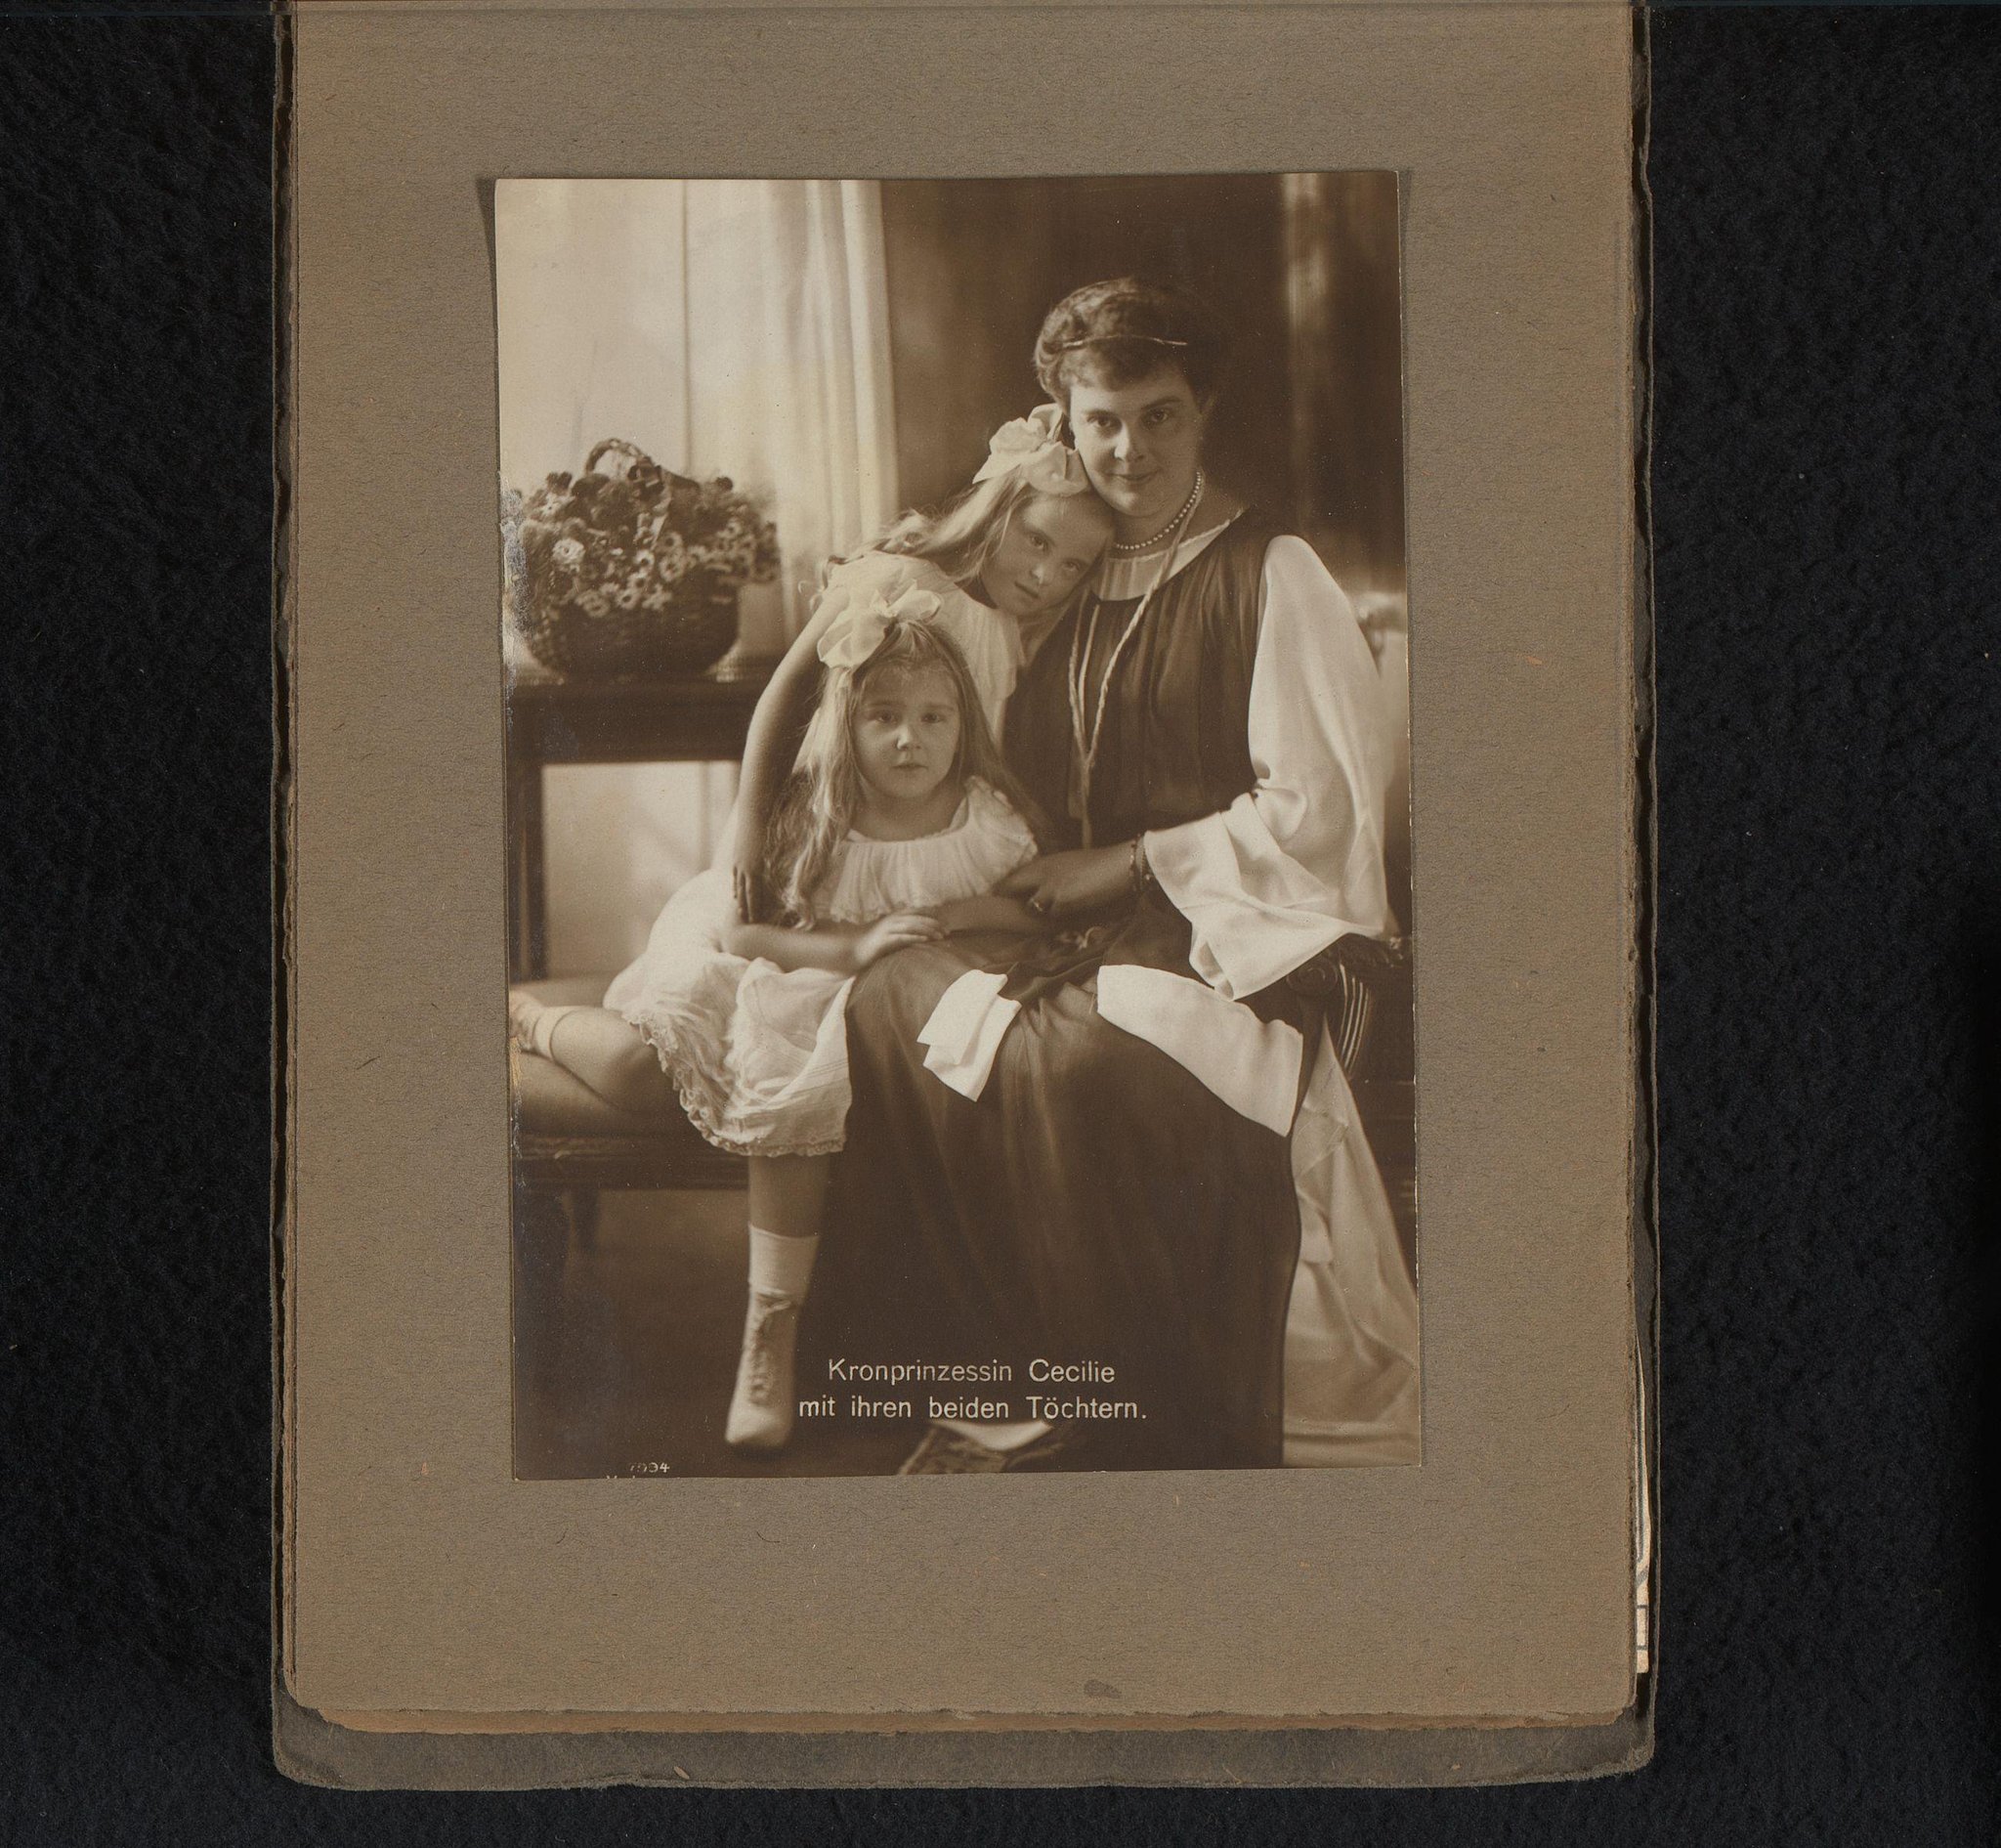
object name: photograph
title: Portret van Cecilie van Mecklenburg-Schwerin met haar dochters Alexandrine van Pruisen en Cecilia van Pruisen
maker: Anonymous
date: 1920-1925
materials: paper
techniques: gelatin silver print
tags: historical persons, princess